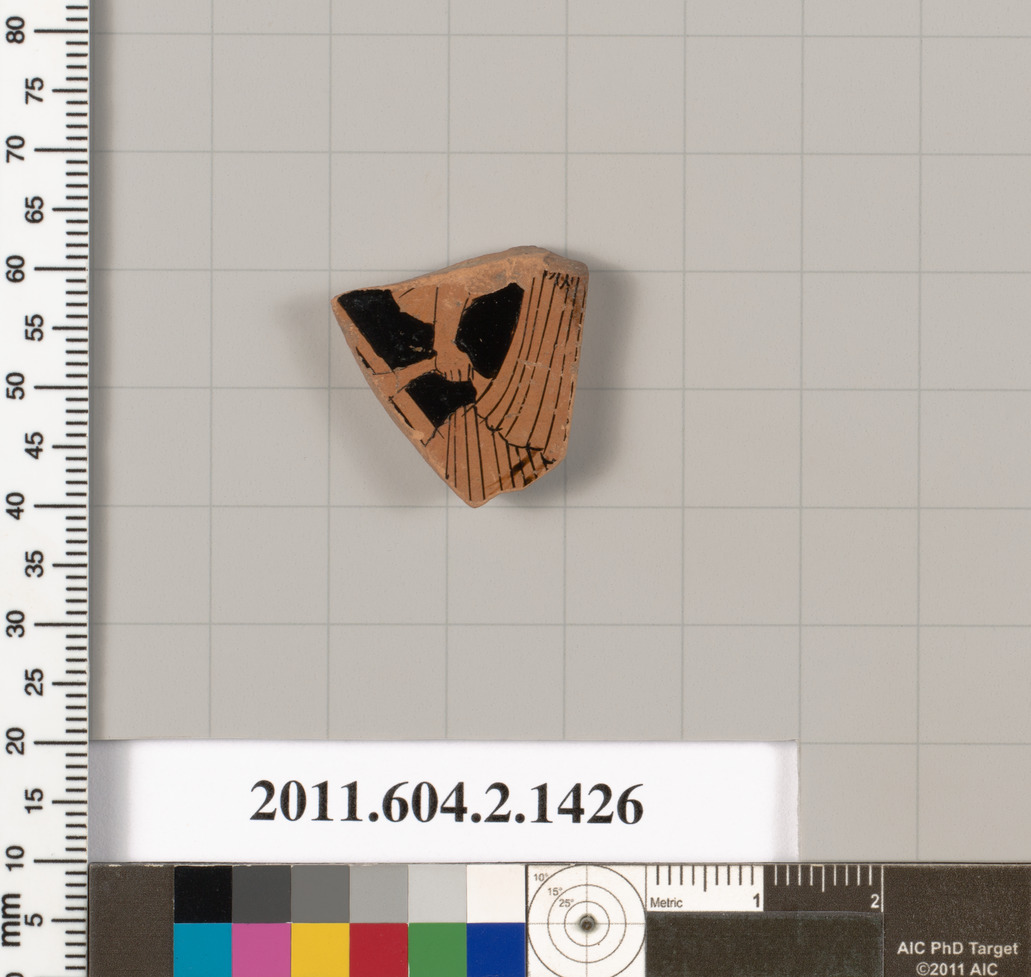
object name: skyphos fragment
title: Terracotta fragment of a skyphos (deep drinking cup)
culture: greek, attic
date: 475-451 BCE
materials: terracotta